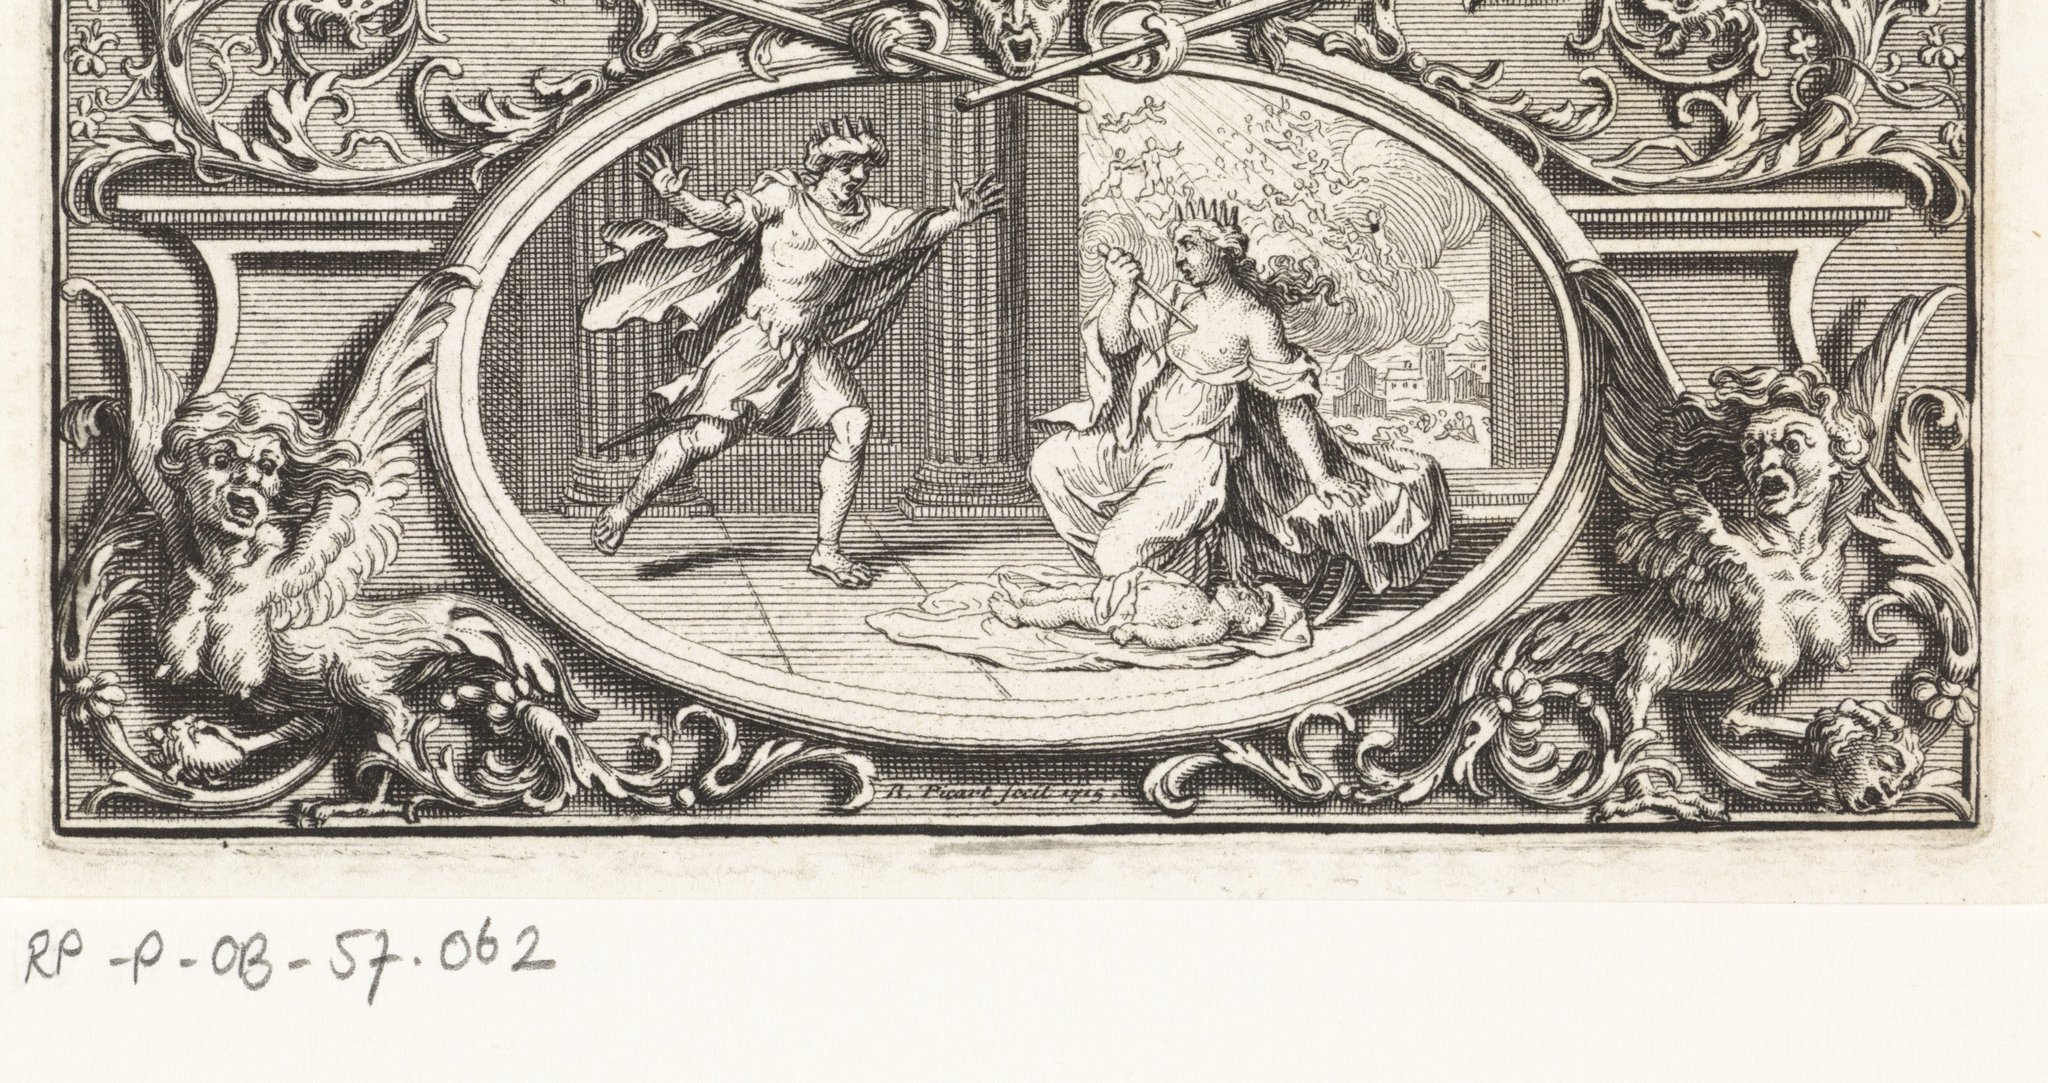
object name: ornament print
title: Zelfmoord van een koningin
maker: bernard picart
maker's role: draughtsman, print maker, publisher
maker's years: 1673-1733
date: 1715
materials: paper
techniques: engraving, etching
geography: amsterdam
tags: ornaments ~ art, queen, empress, etc. (wife of a ruler), harpy (fabulous bird); 'arpie' (ripa), suicide out of despair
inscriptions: collector's mark: Lugt 240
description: Een gekroonde vrouw doorsteekt haar borst met een dolk. Aan haar voeten ligt een gestorven kind. Een koning komt toegesneld. In de onderhoeken van de ornamentele omlijsting harpijen.